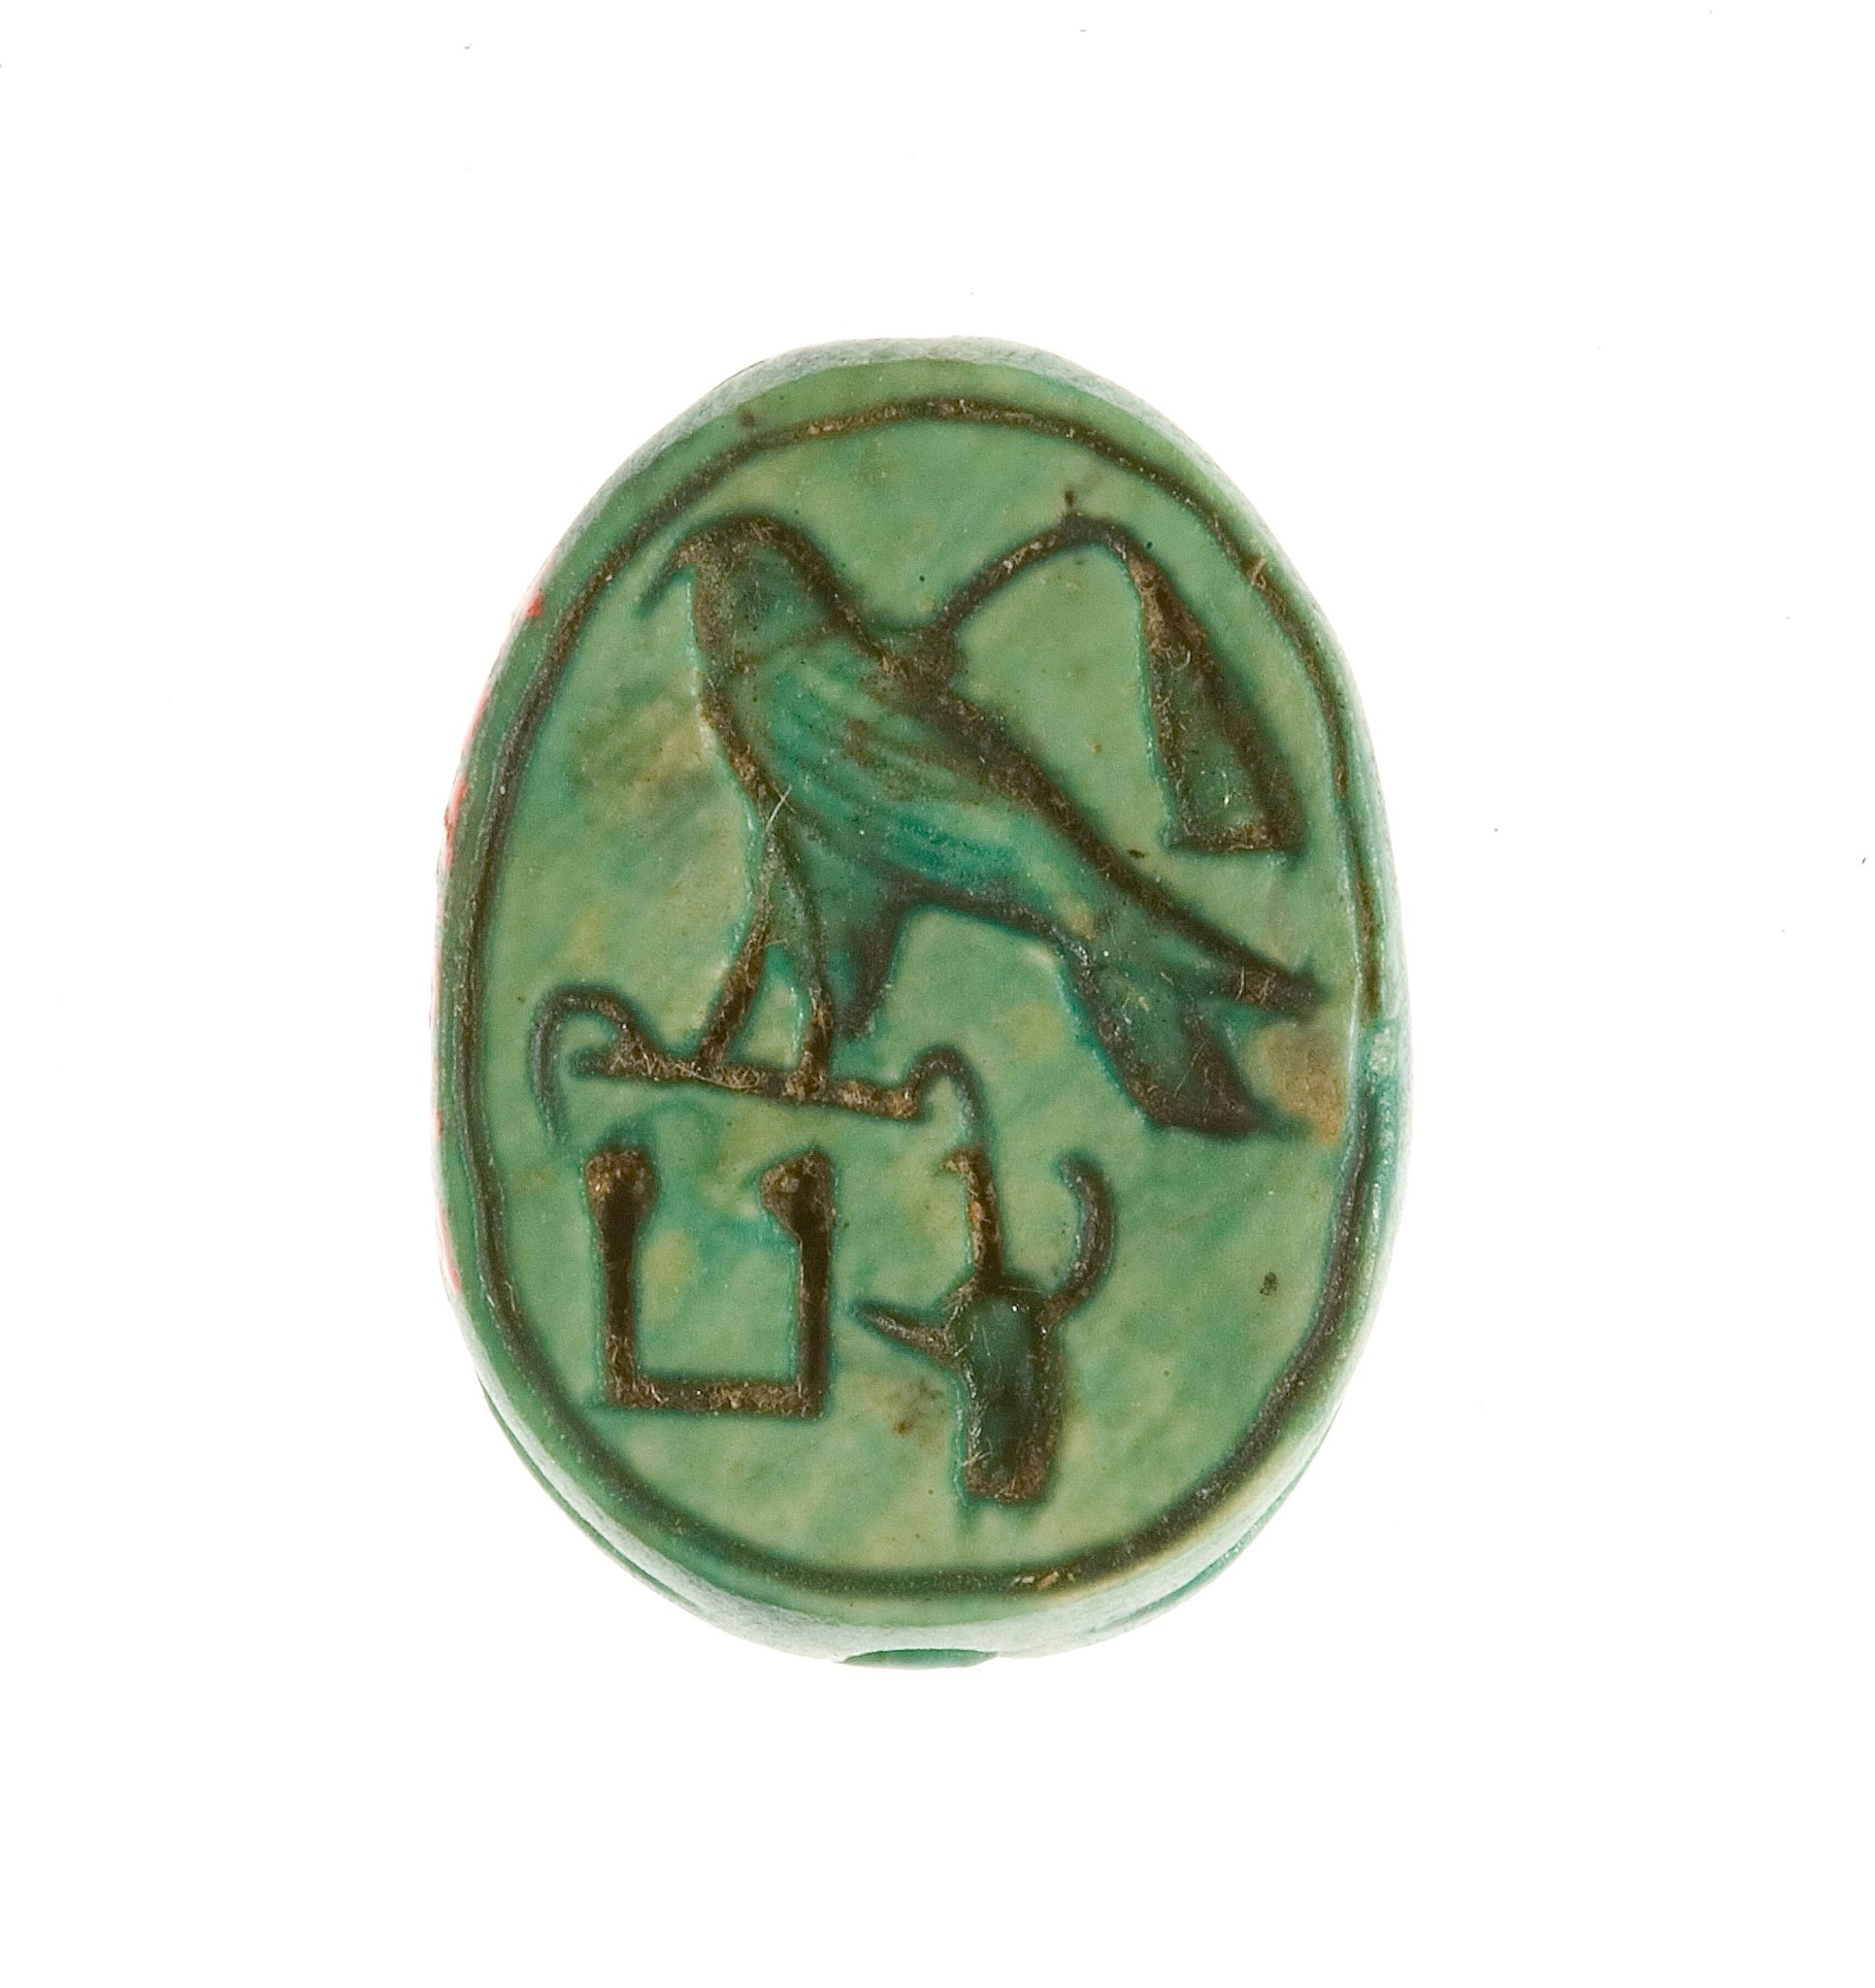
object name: scarab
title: Scarab Inscribed for the Horus Wosretkau (Hatshepsut)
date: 1479-1458 BCE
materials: stone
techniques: glazing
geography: egypt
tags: birds,scarabs